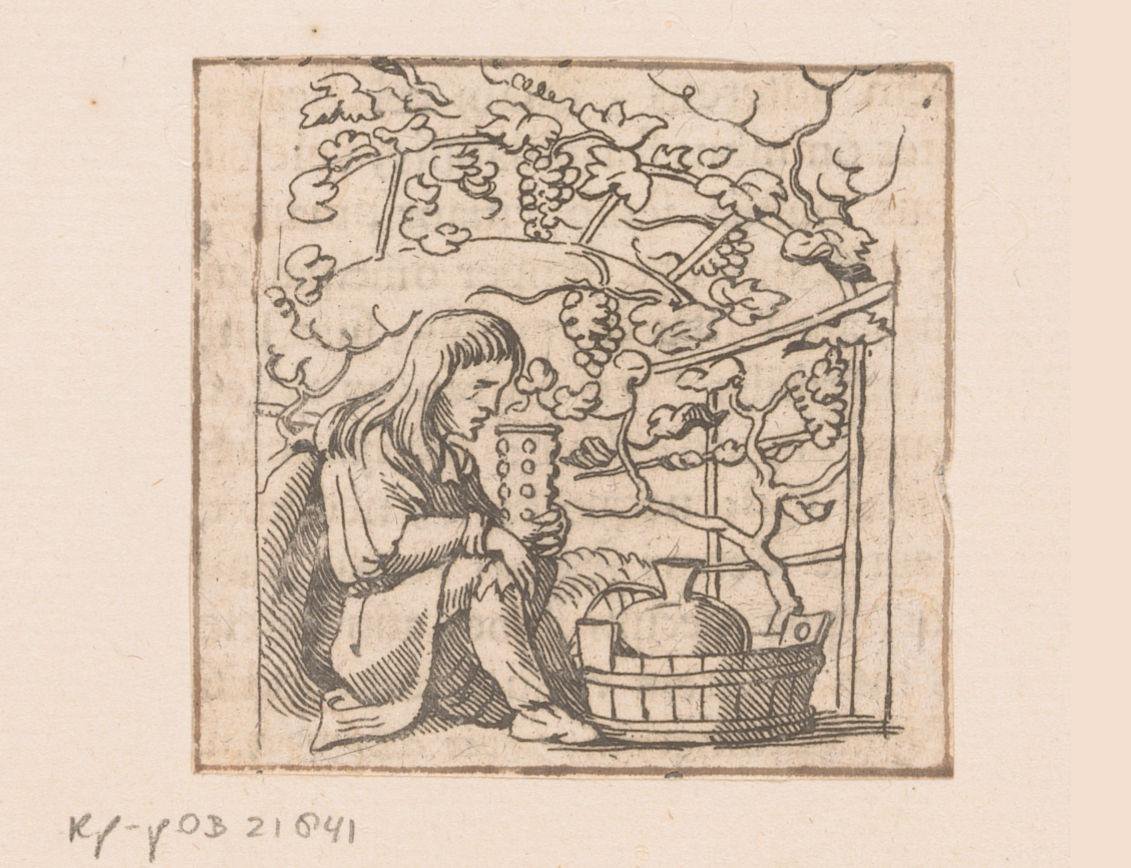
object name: book illustration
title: Illustraties uit de Lof der Zotheid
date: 1516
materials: paper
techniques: etching, letterpress printing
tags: rotterdam, desiderius erasmus, drunkenness, folly, foolishness; 'pazzia', 'sciocchezza', 'stoltitia' (ripa)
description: Prent afkomstig uit: Erasmus, Desiderius. Morias enkomion (...). Bazel: Johann Rudolf Genath, 1676. De prenten hierin zijn naar tekeningen die Hans en Ambrosius Holbein maakten voor de theoloog Oswald Myconius in diens uitgave van de Moriae encomium (Lof der Zotheid) van 1516.